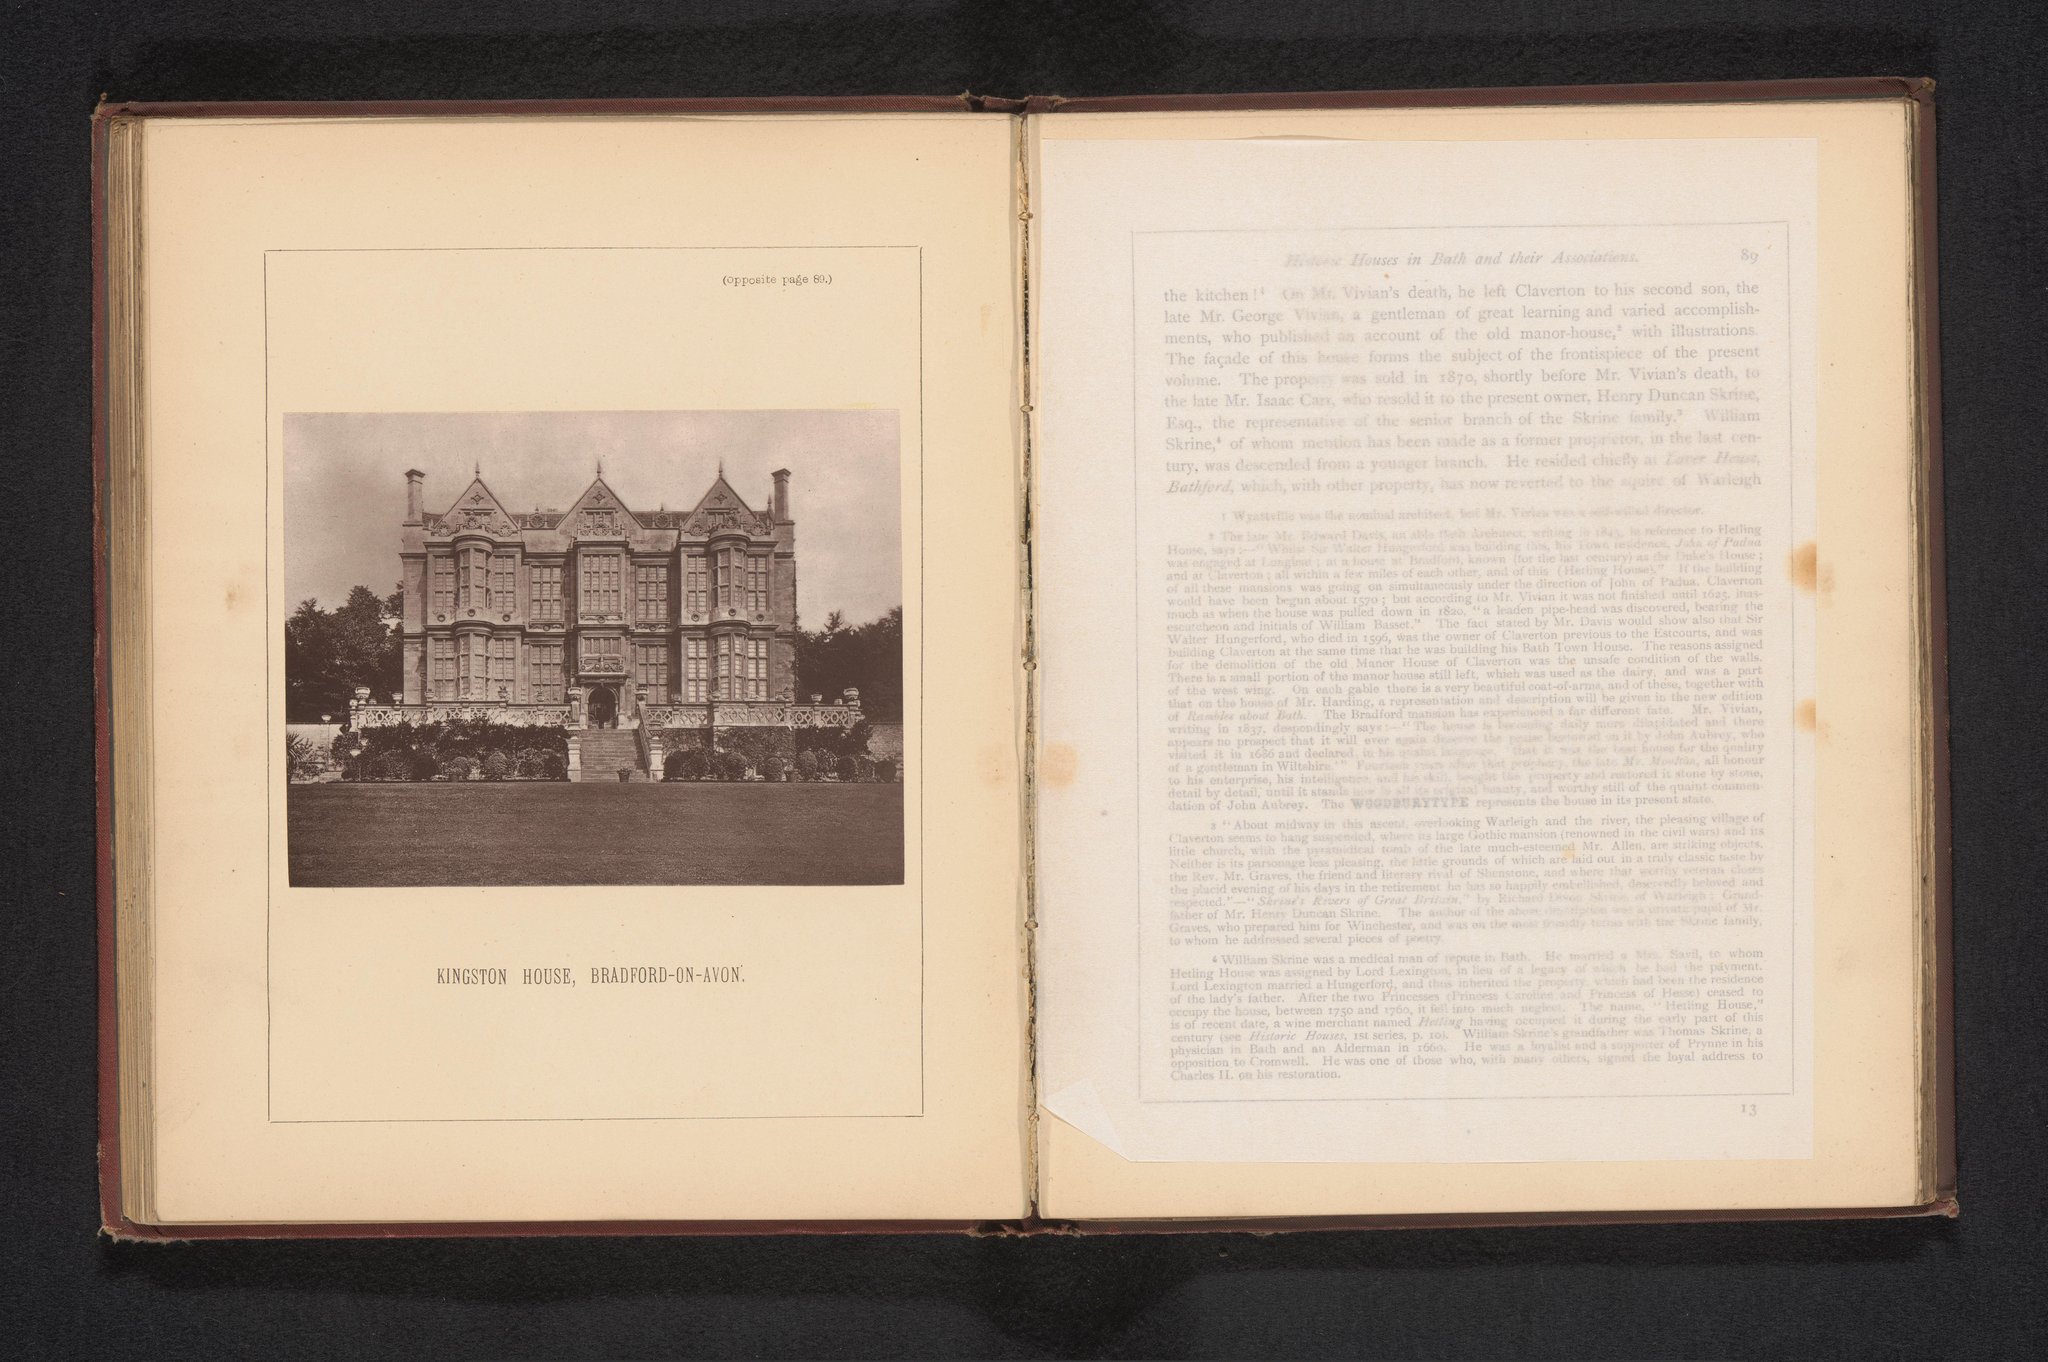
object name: page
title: Gezicht op Kingston House in Bradford-on-Avon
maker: Anonymous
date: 1879-1884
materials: paper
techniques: woodburytype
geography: bradford-on-avon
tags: villa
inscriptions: inscription: ‘(Opposite page 89.)’